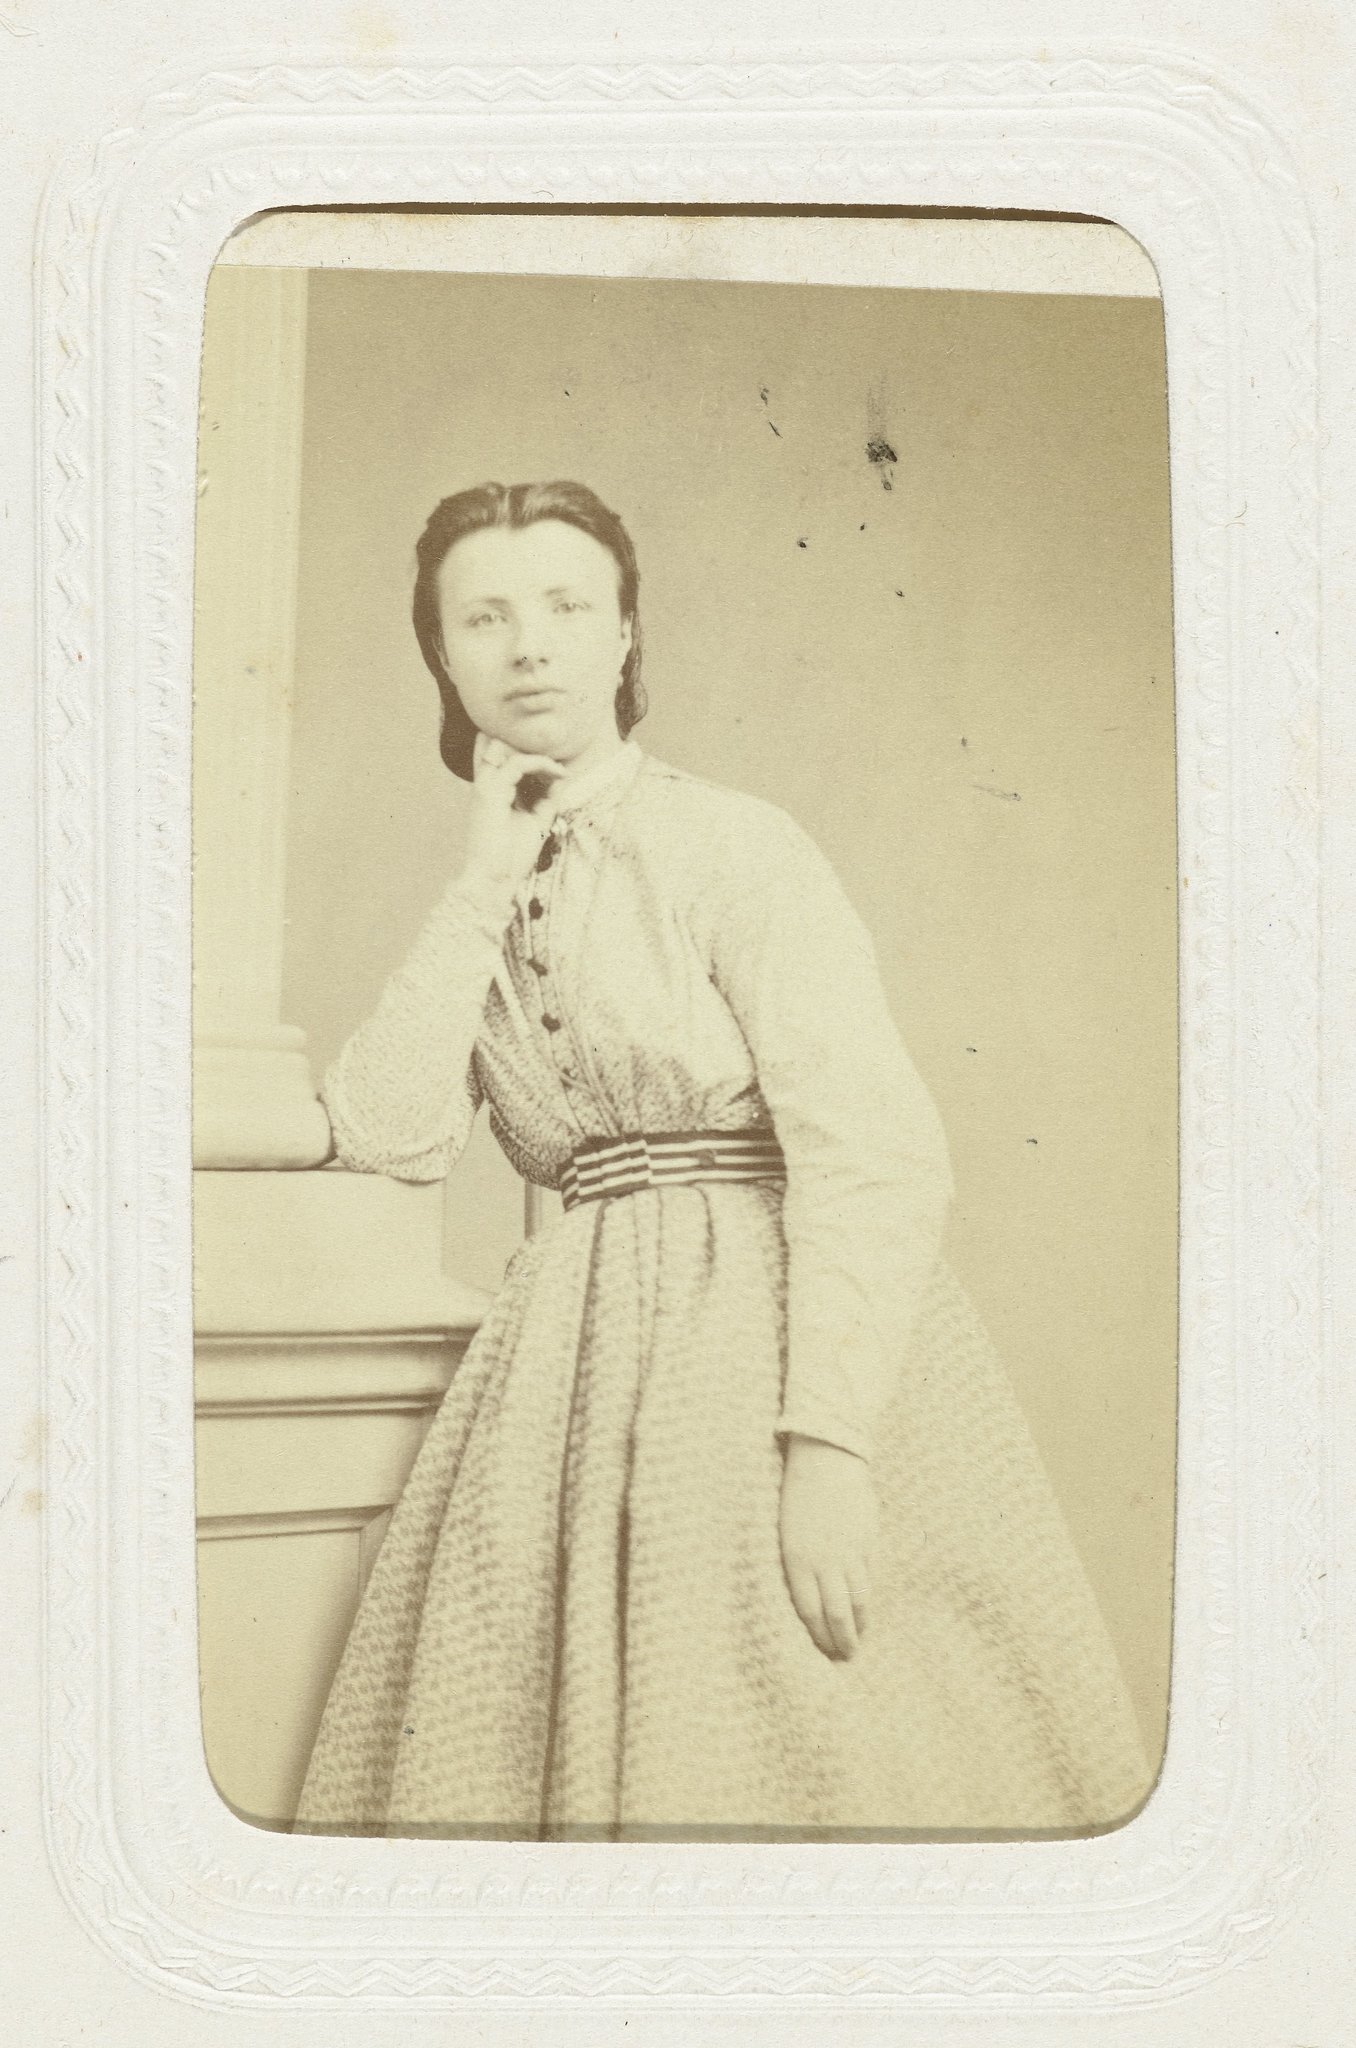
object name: carte de visite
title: Studioportret van een jonge vrouw in een lange zwarte jurk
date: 1863-1866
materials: cardboard, paper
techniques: albumen print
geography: amsterdam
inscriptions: name: ‘S. van Caspel & Stapert, Bloemgracht D.D. 43 Amsterdam’